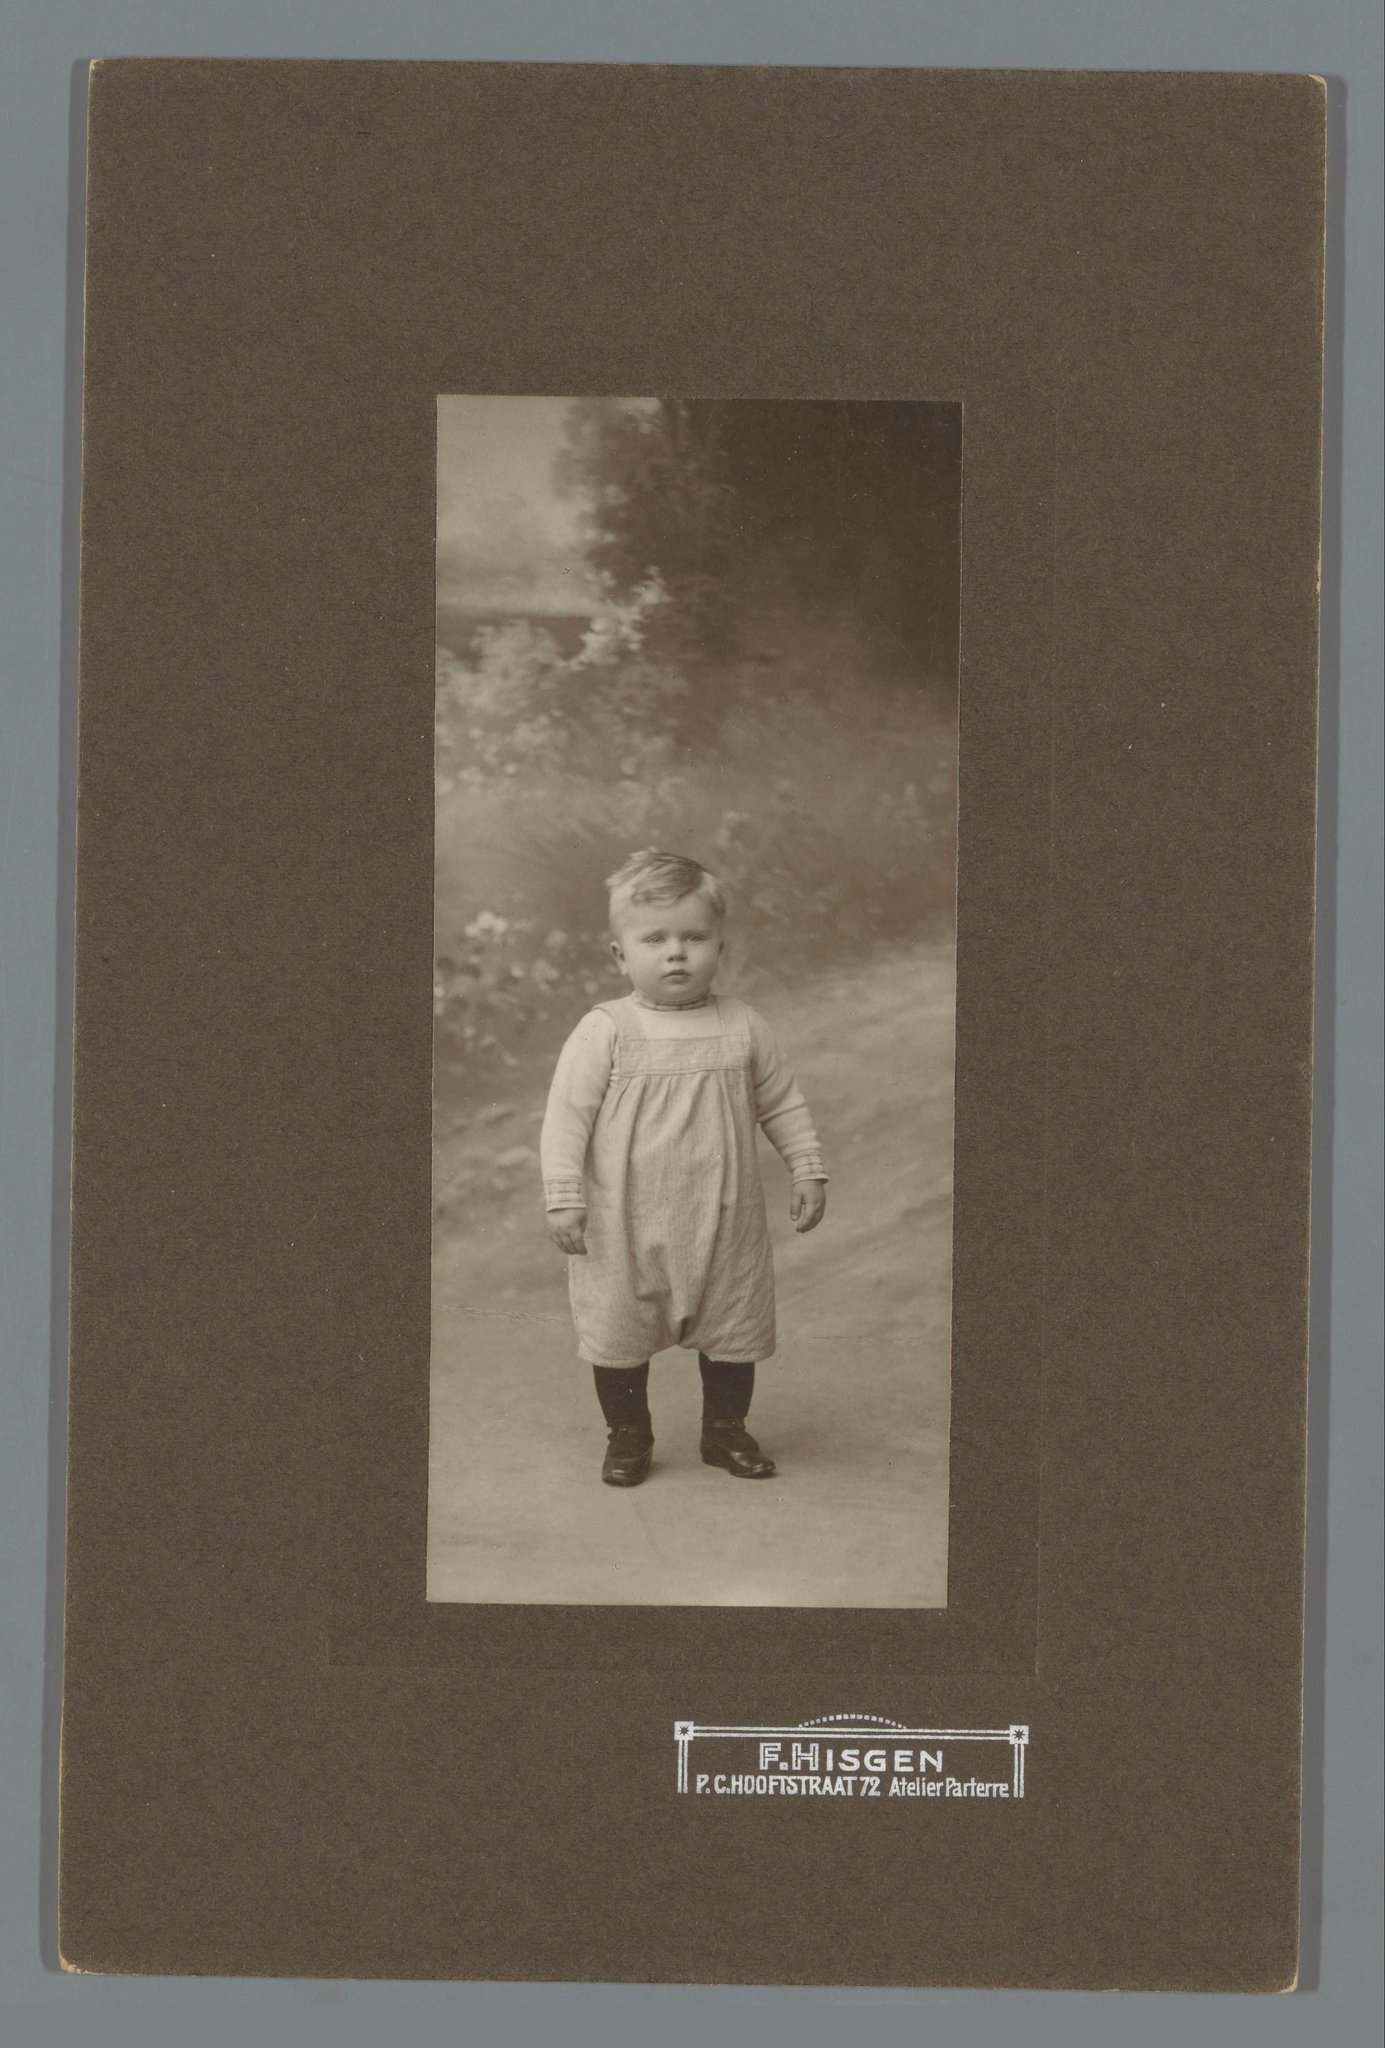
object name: cabinet photograph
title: Portret van een jongen in een kruippakje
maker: friedrich carel hisgen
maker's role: fotograaf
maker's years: 1846-1912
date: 1891-1912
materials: cardboard, photographic support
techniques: gelatin silver print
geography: amsterdam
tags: family, descendance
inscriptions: name: ‘Famlles Gra[...]er er Röber’, name: ‘A. Hoegg Plauen b. Dresden Räcjuitzerstr. 31.’